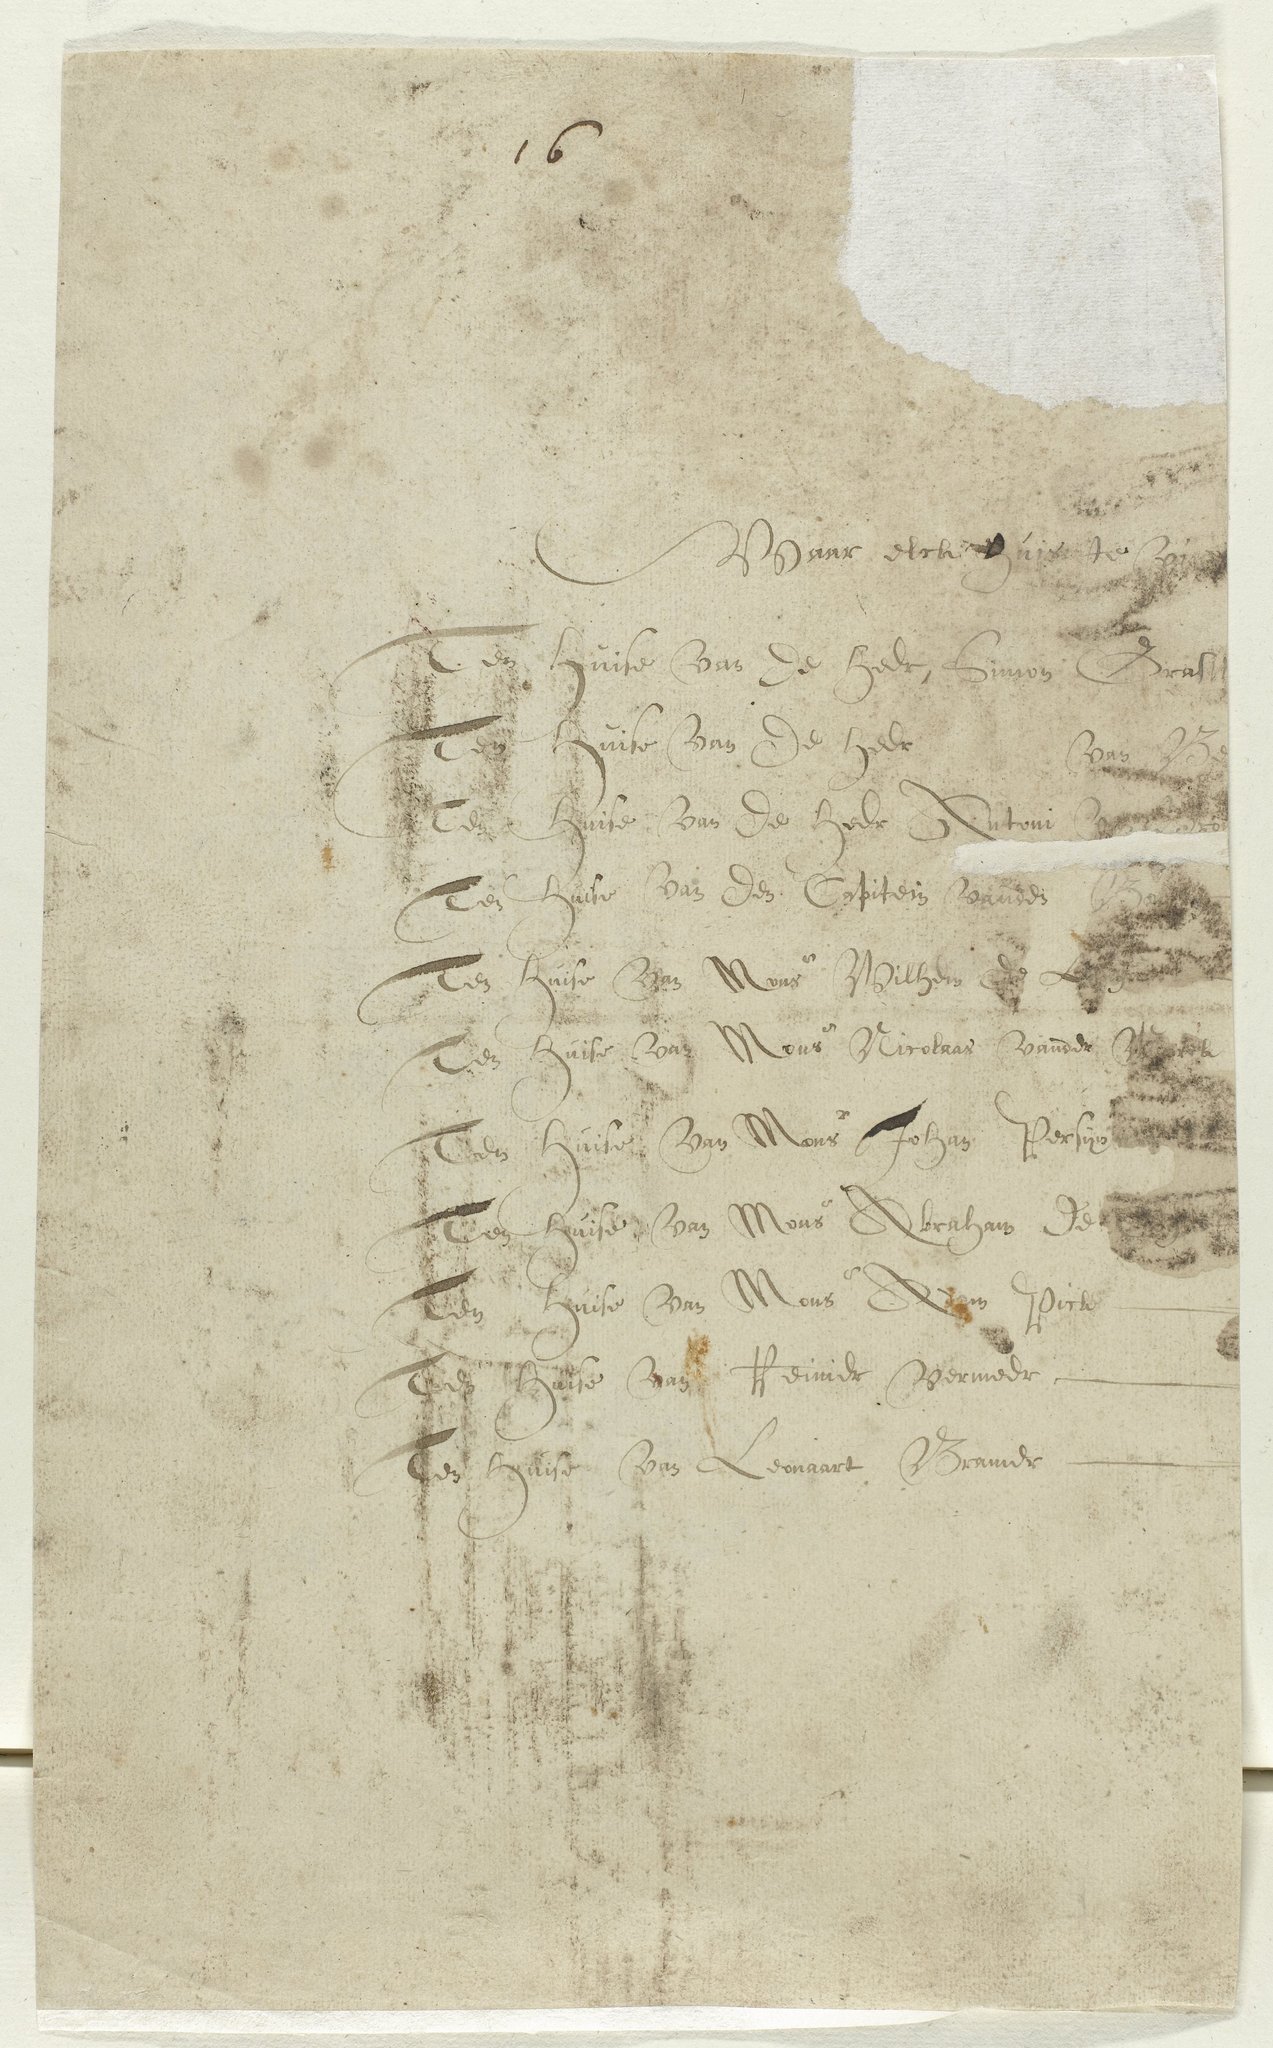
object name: album leaf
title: Namenlijst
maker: leonaert bramer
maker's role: draughtsman, painter, print maker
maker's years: 1596-1674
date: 1642-1653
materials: ink, paper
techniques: pen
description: Vermoedelijk een lijst met de namen van personen in wiens huis de schilderijen te vinden waren waar de tekeningen uit het album op gebaseerd zijn. Document maakt onderdeel uit van een album.